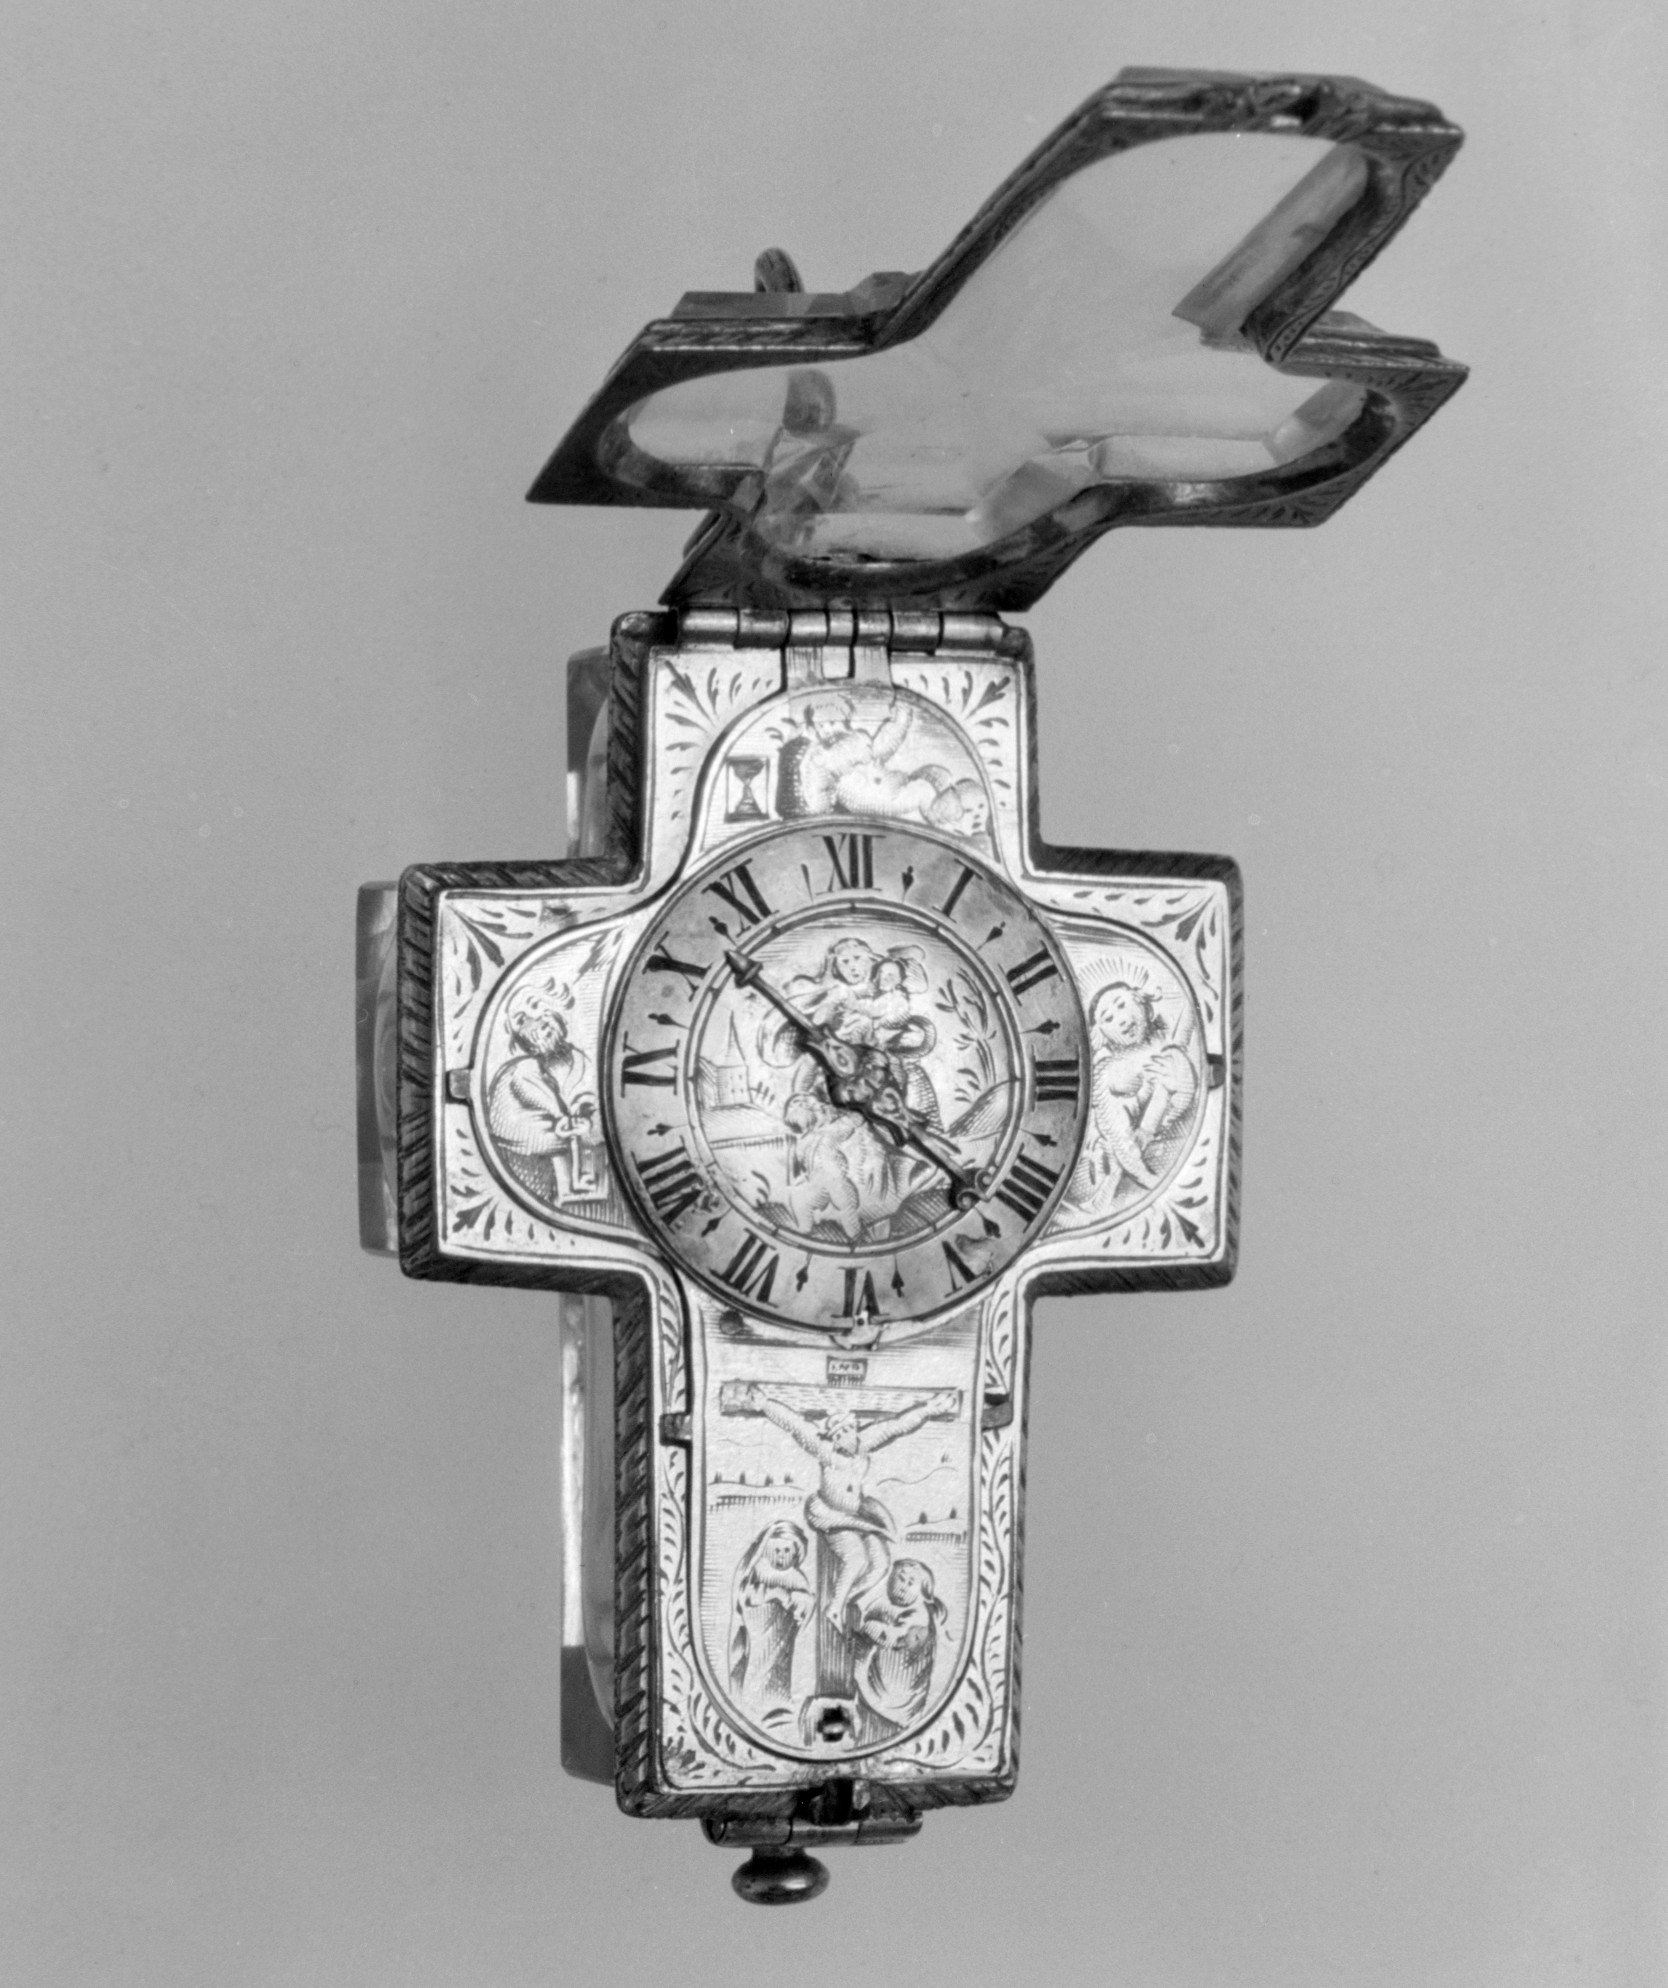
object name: watch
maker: abraham bobinet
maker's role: maker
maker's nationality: swiss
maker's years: 1639-1688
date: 1660-1680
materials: gilt brass, quartz, silver, steel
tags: christ,madonna and child,cross,crucifixion